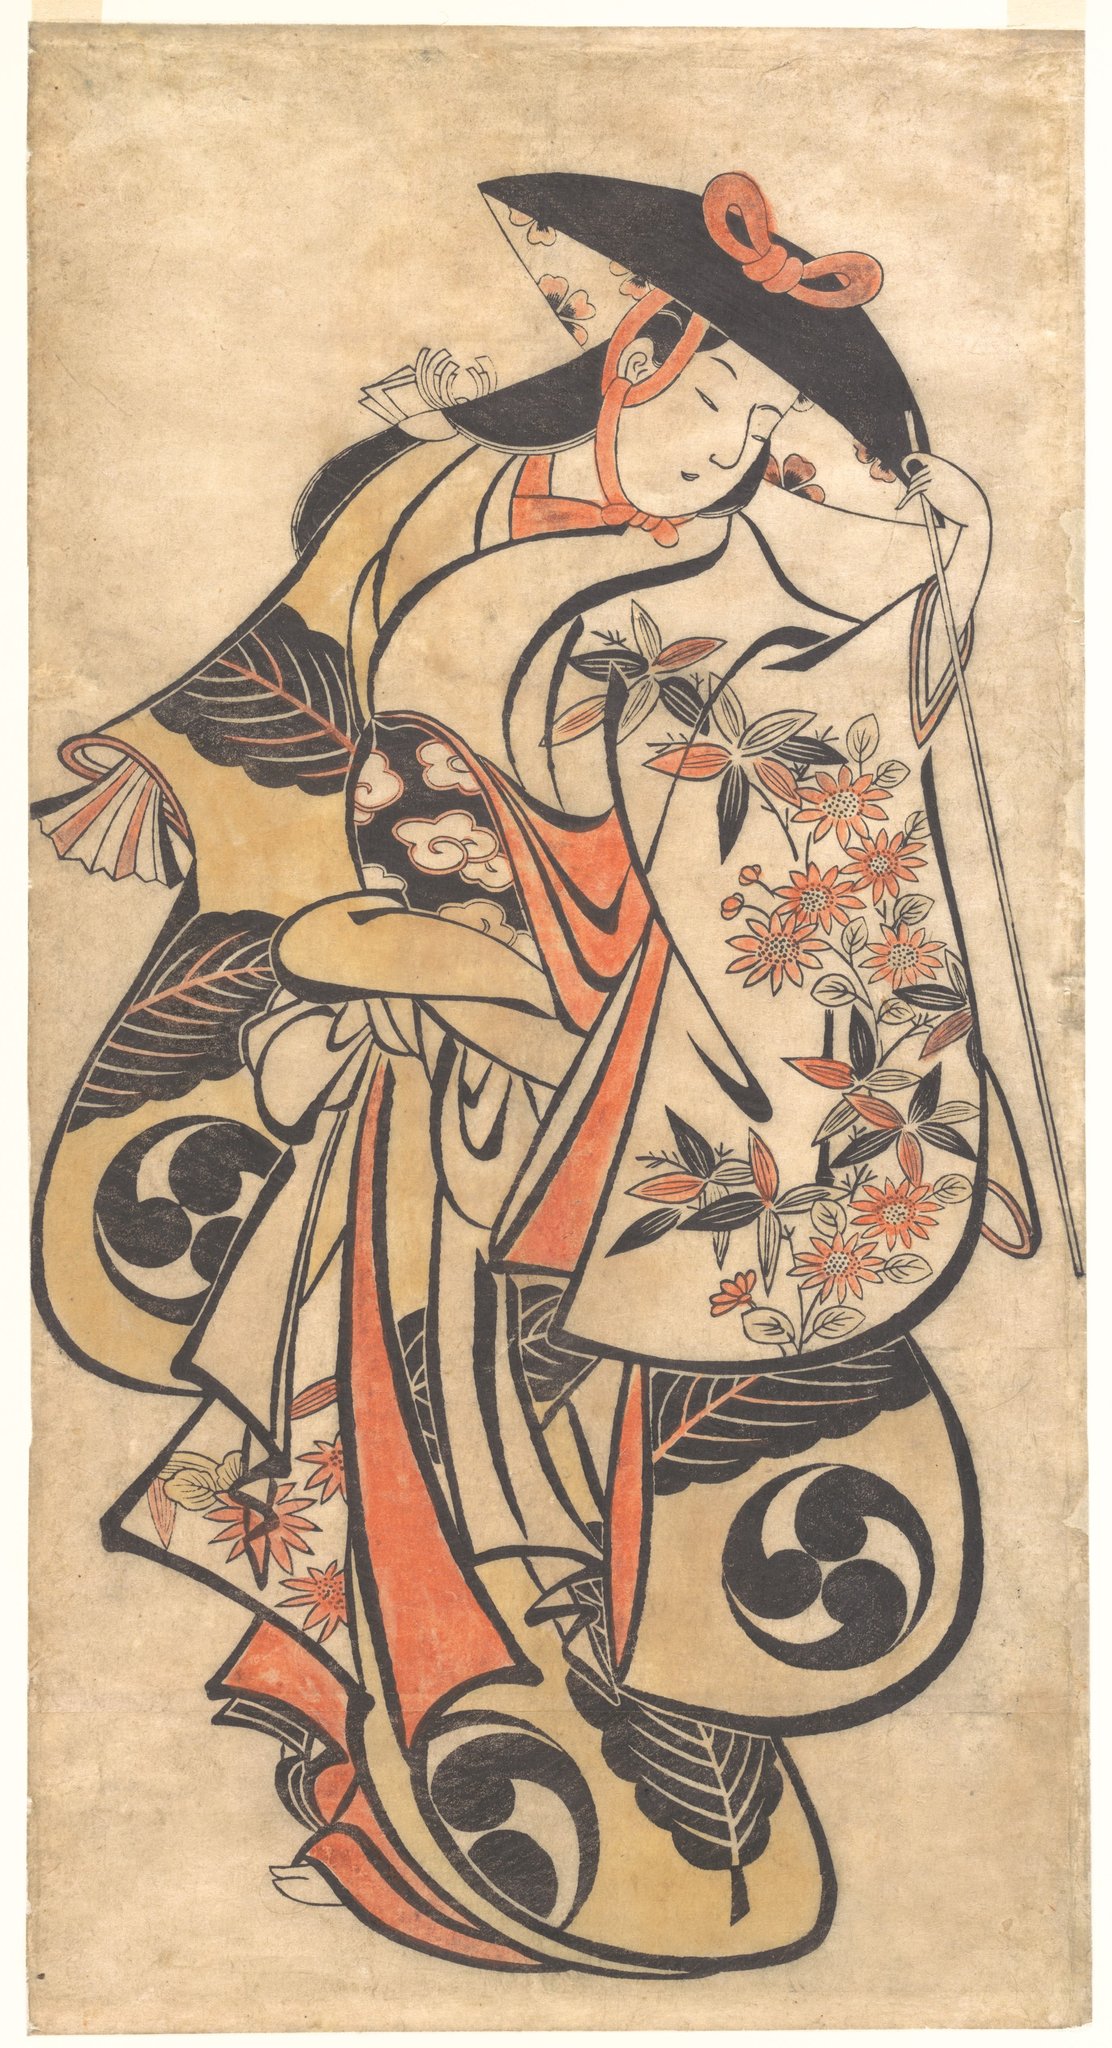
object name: woodblock print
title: Kabuki Actor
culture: japanese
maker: torii kiyonobu i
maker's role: artist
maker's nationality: japanese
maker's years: 1664-1729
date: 1708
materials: ink, paper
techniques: woodblock print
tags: women,actors